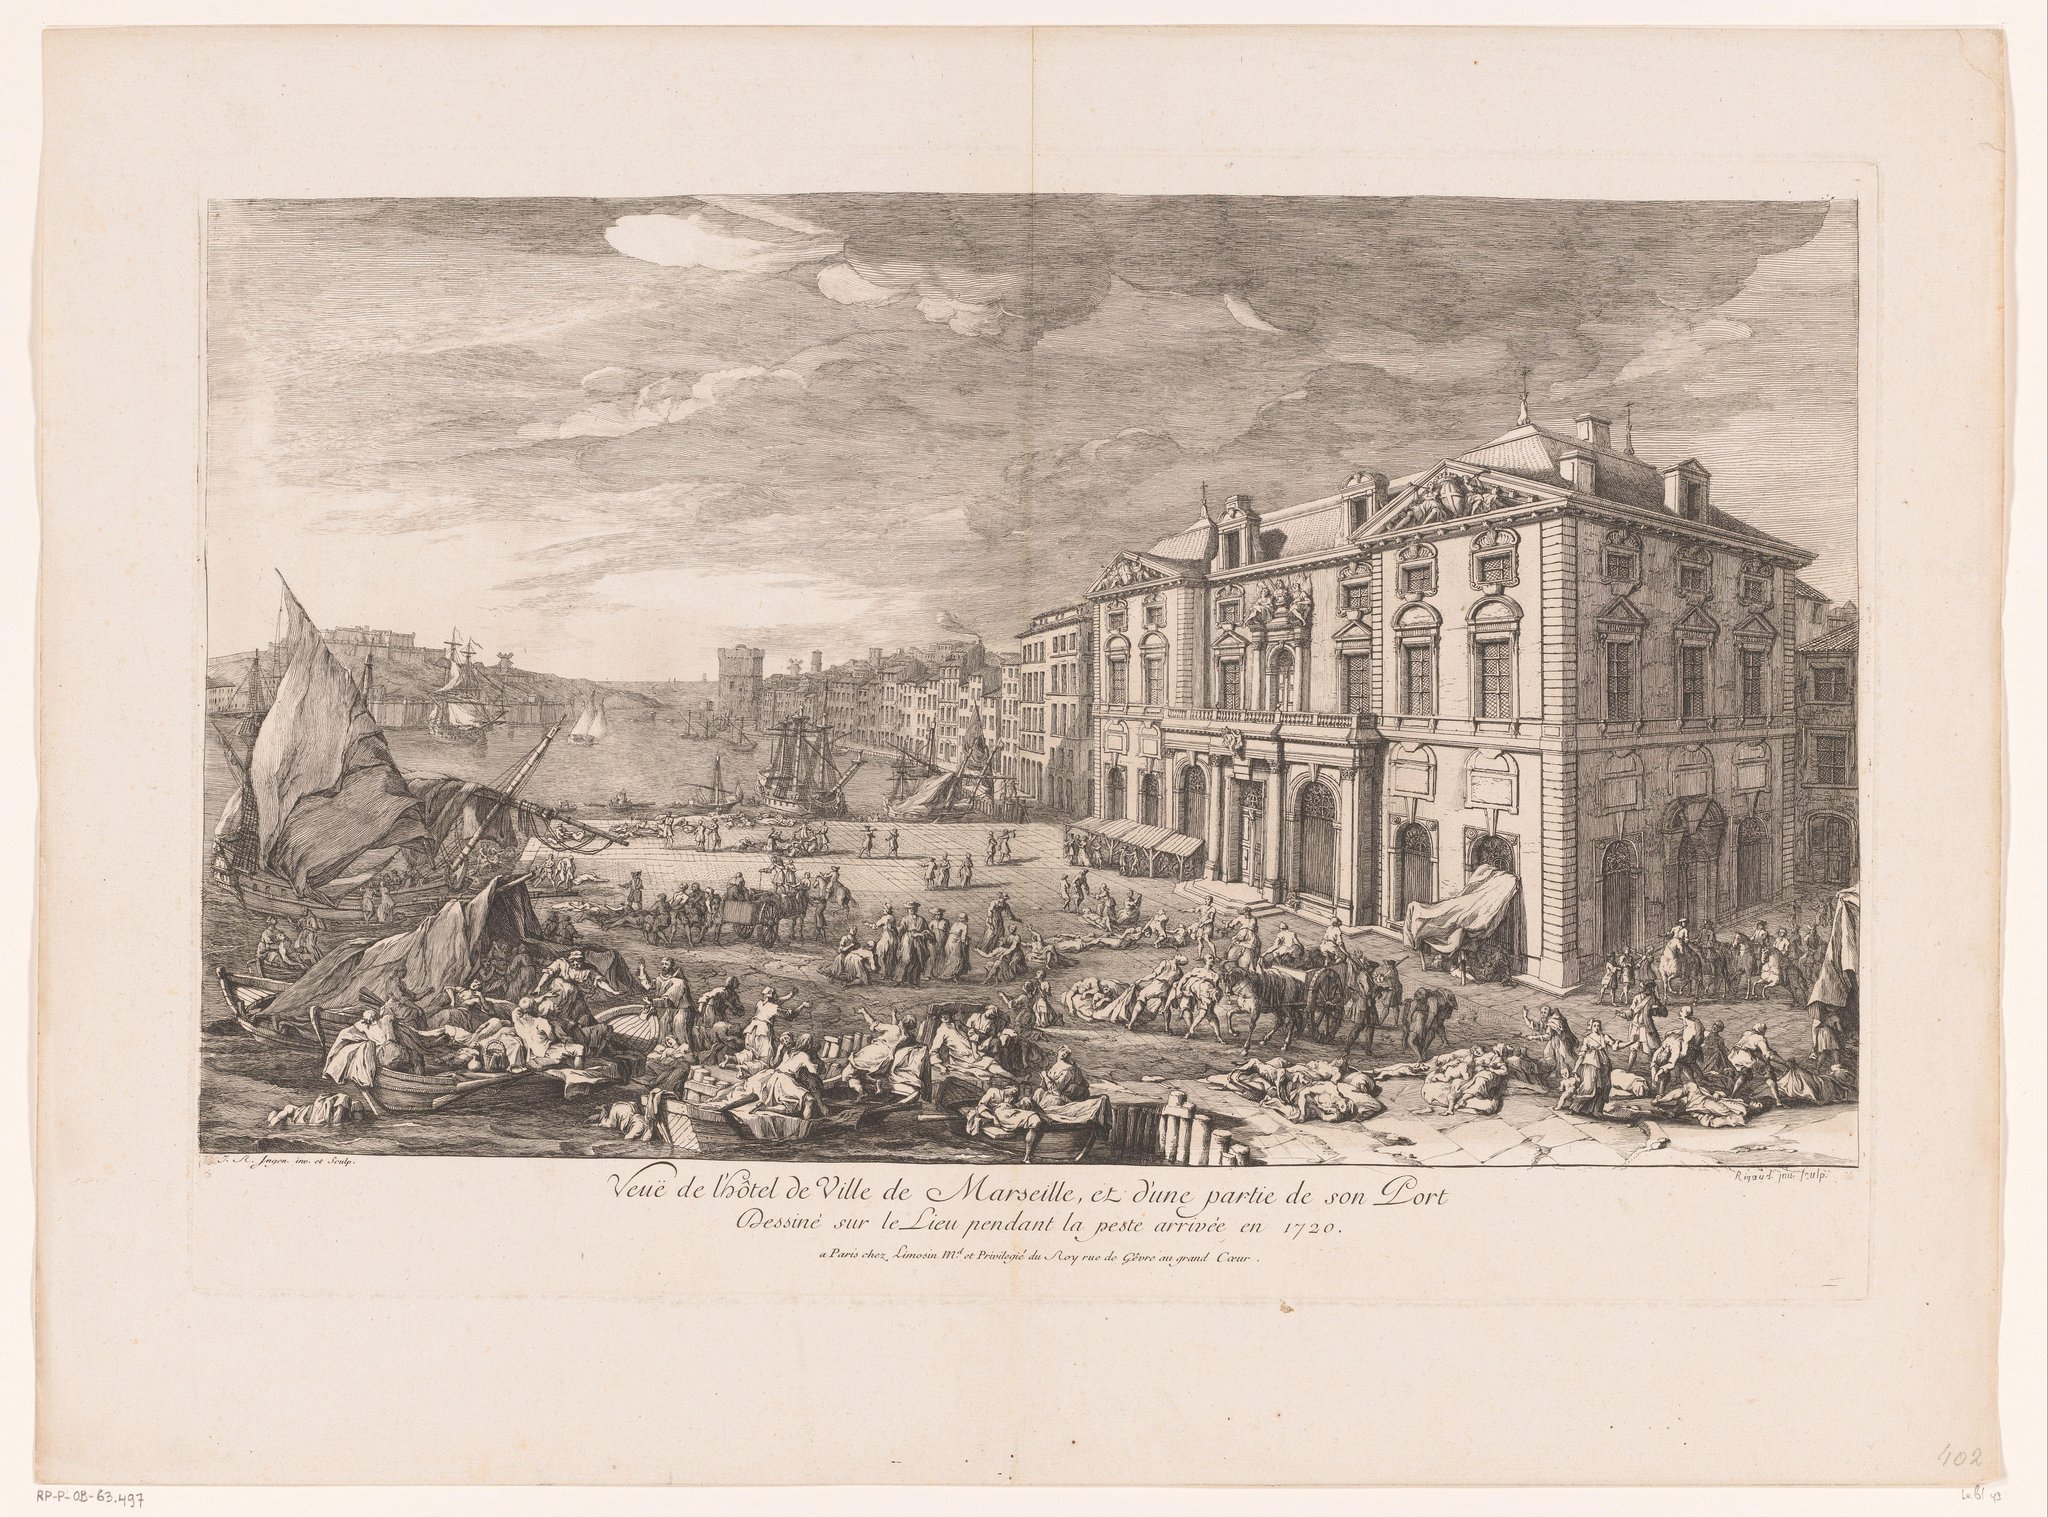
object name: print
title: Veuë de l'hôtel de Ville de Marseille, et d'une partie de son Port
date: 1720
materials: paper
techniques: etching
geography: france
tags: harbour, plague, marseille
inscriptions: collector's mark: Lugt 240